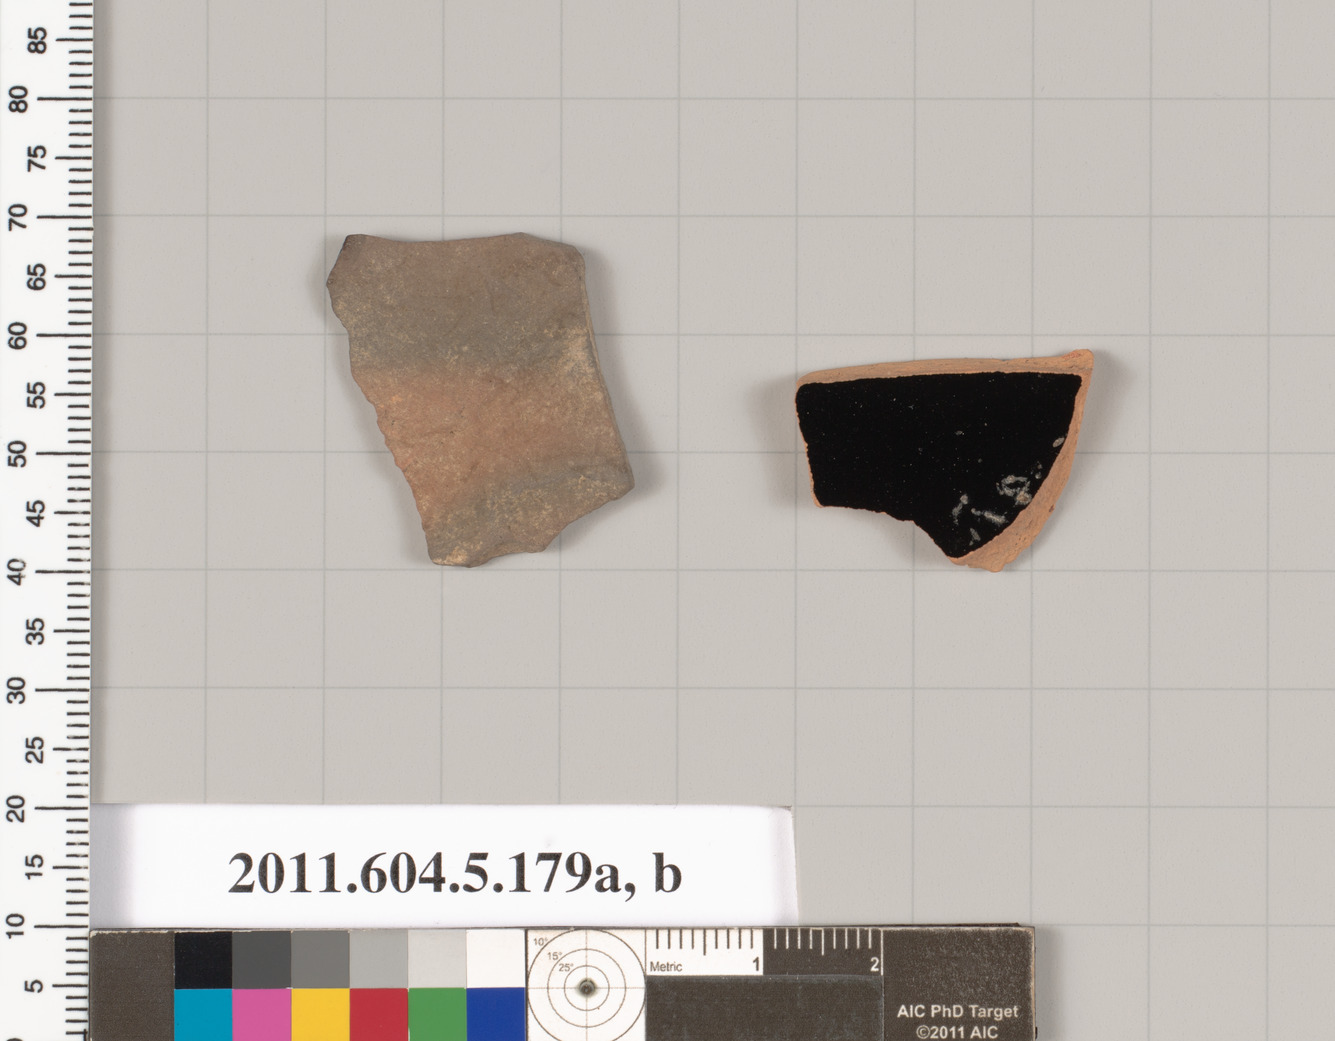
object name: kylix fragment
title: Terracotta fragments of kylikes (drinking cups)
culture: greek, attic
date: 600-401 BCE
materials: terracotta